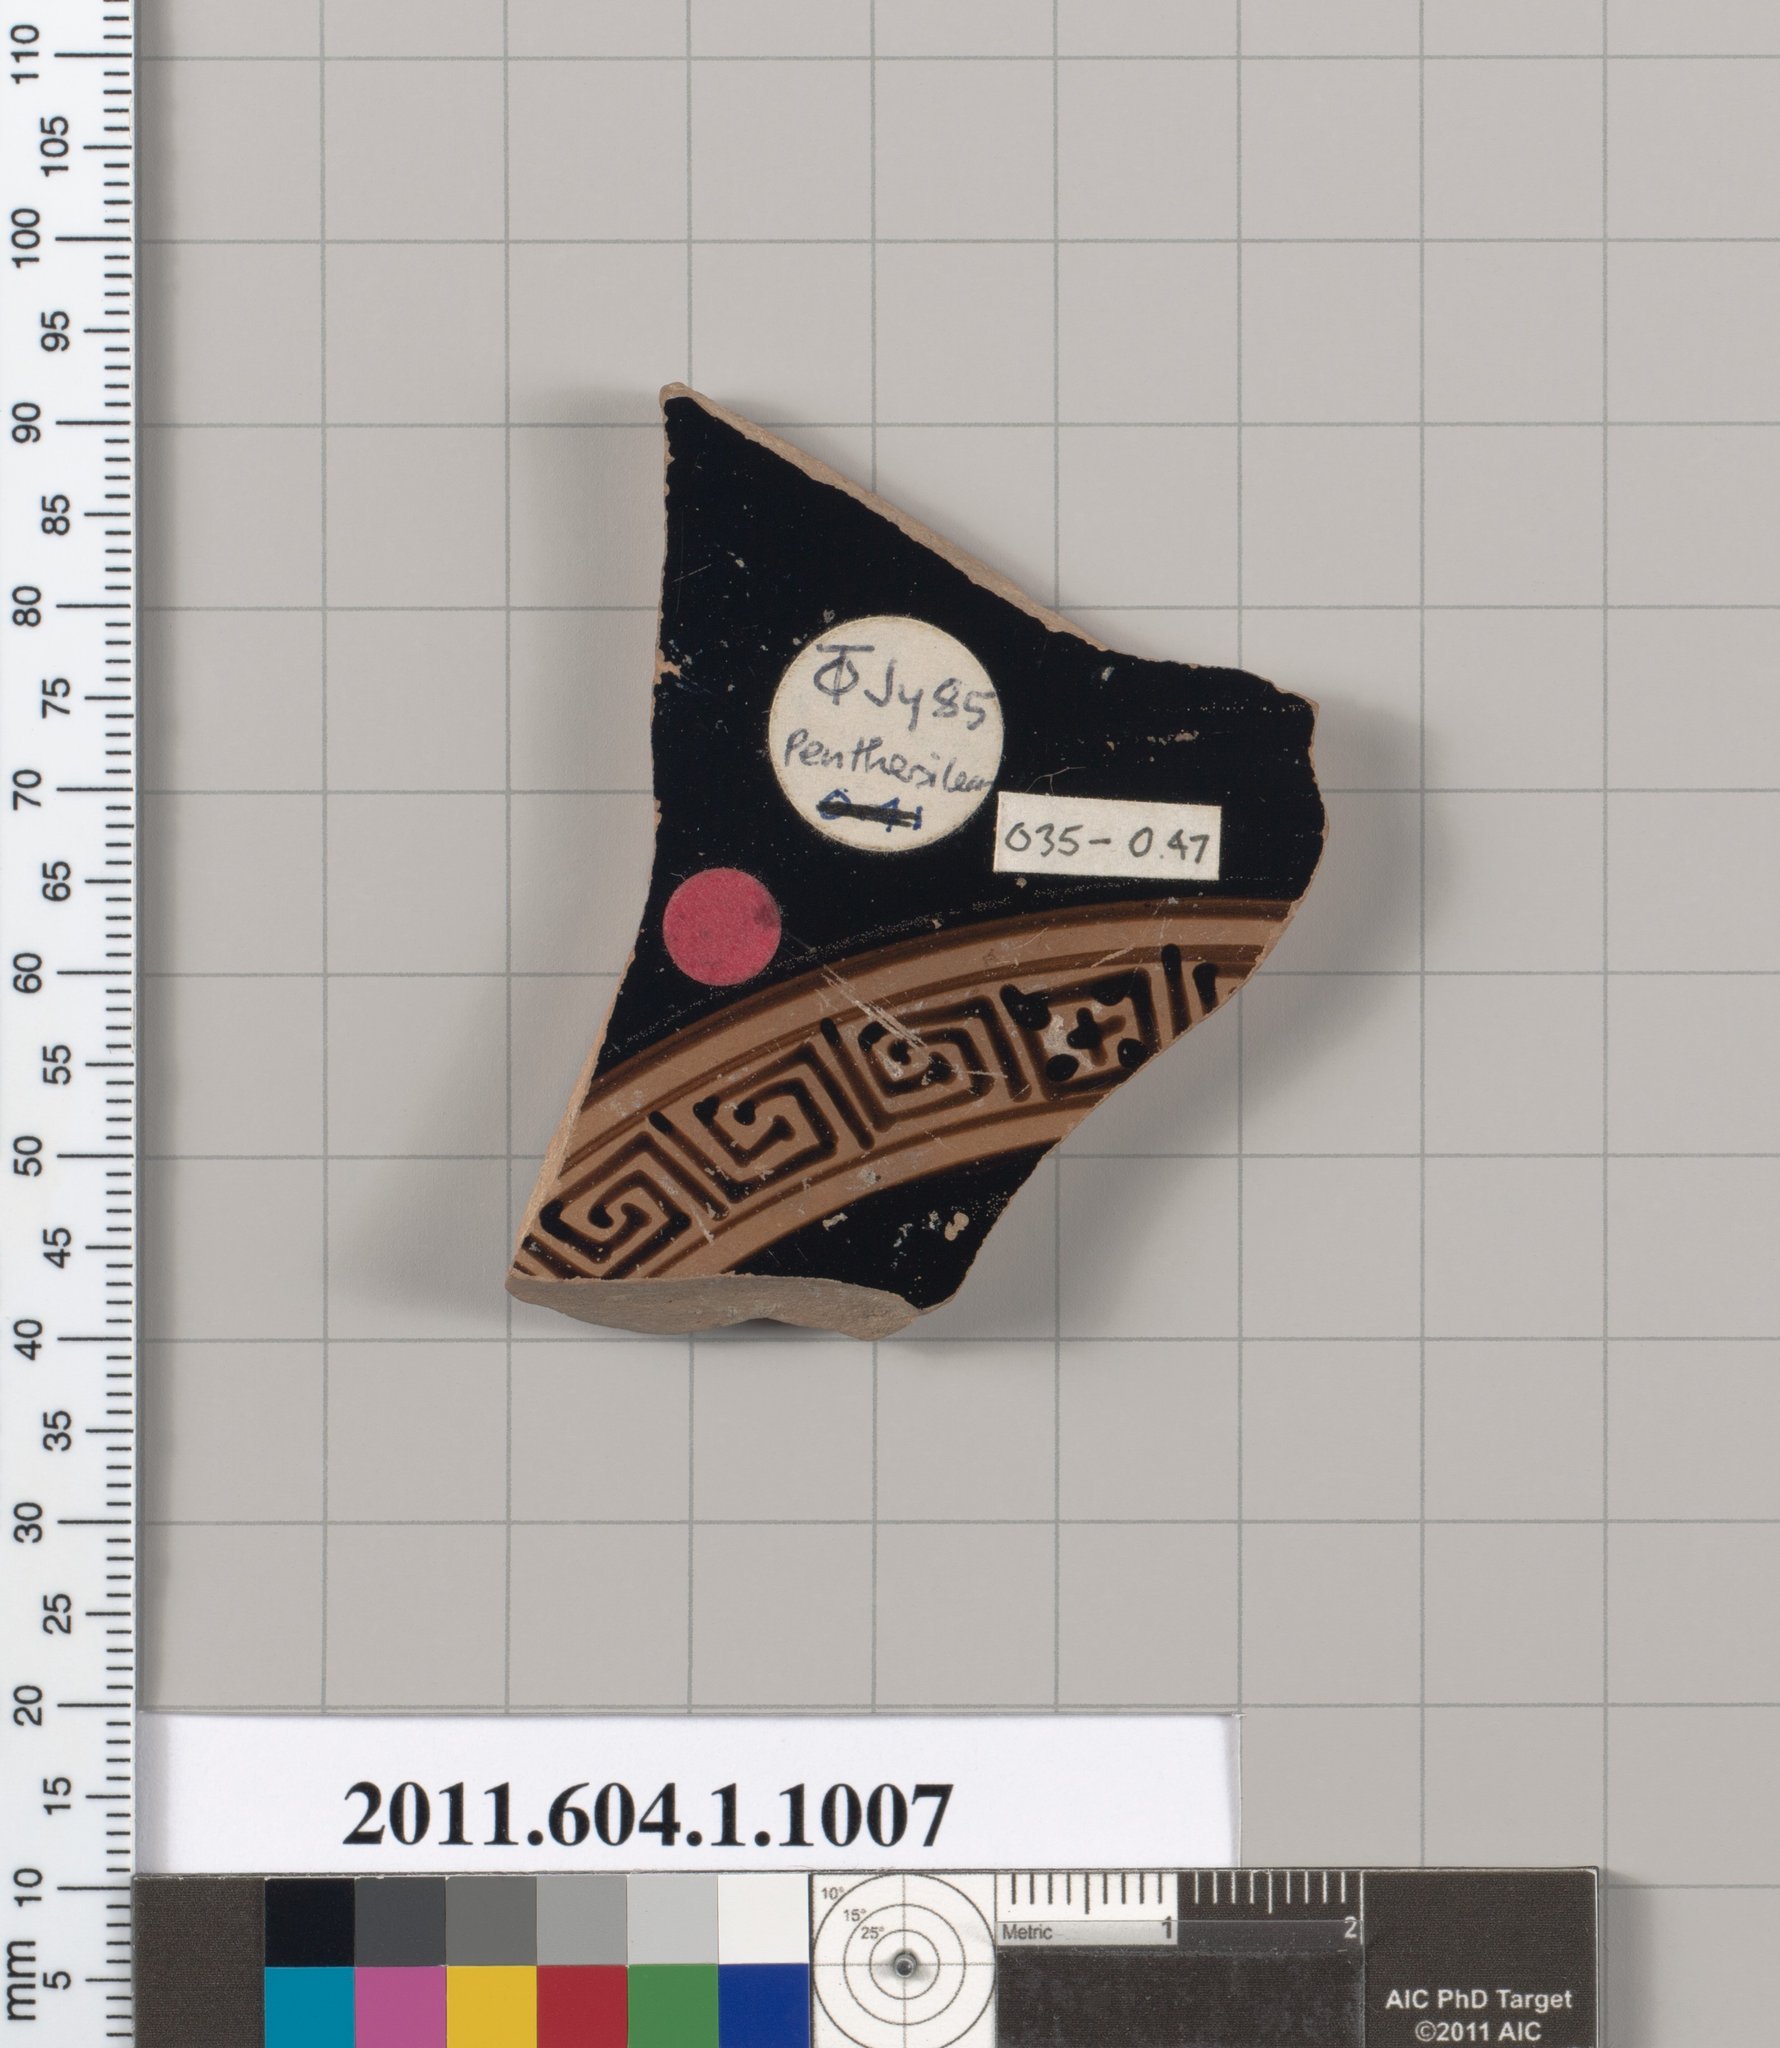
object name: kylix fragment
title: Terracotta fragment of a kylix (drinking cup)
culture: greek, attic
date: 475-451 BCE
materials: terracotta